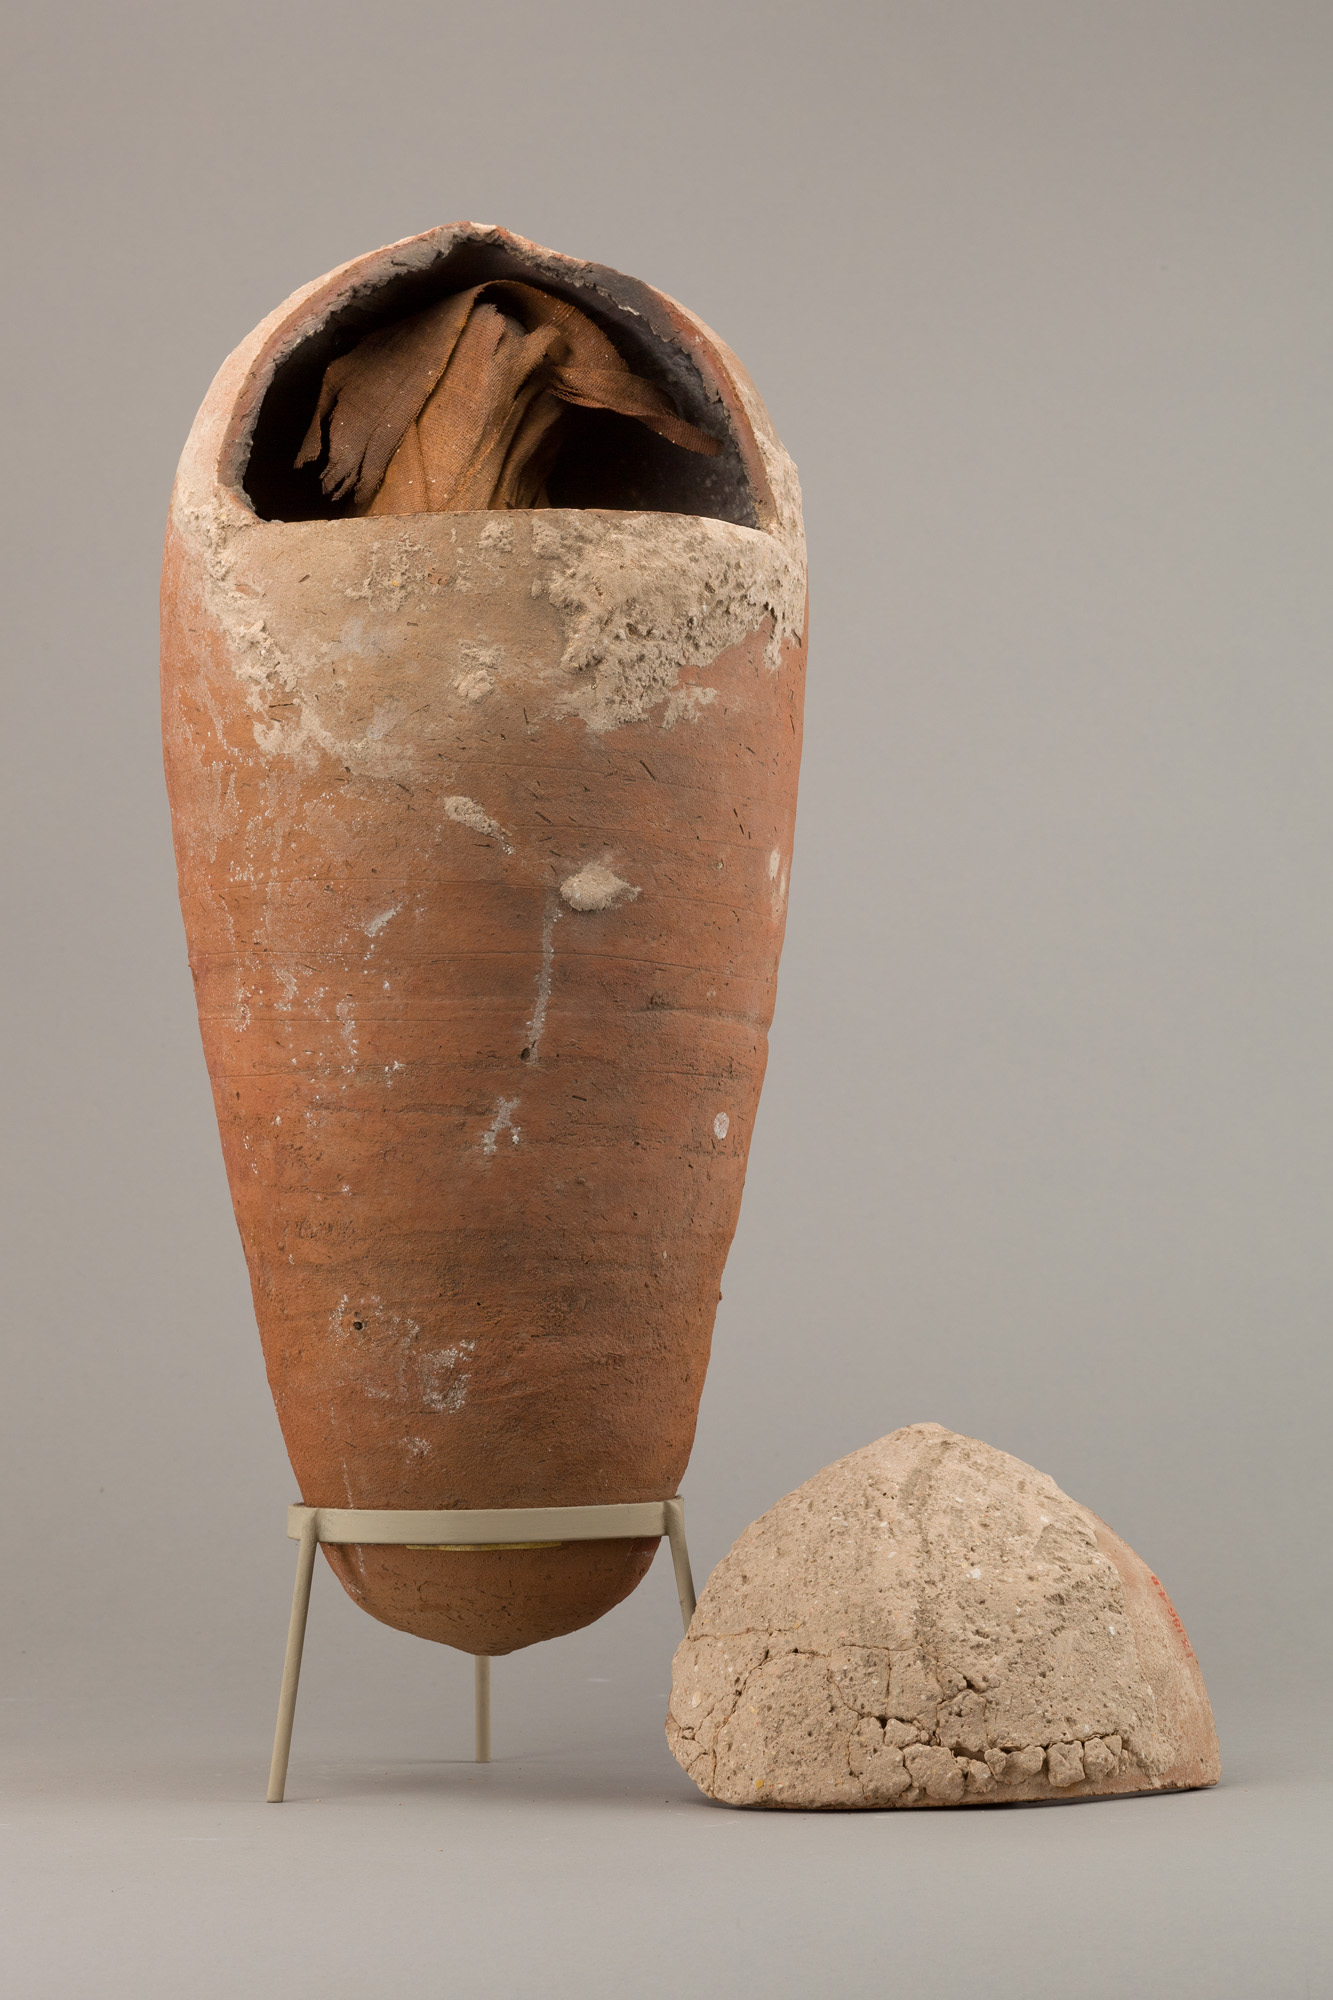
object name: jar, ibis mummy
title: Sacred animal mummy of an ibis inside a jar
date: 400 BCE-100 CE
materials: linen, pottery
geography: egypt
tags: animals,mummies